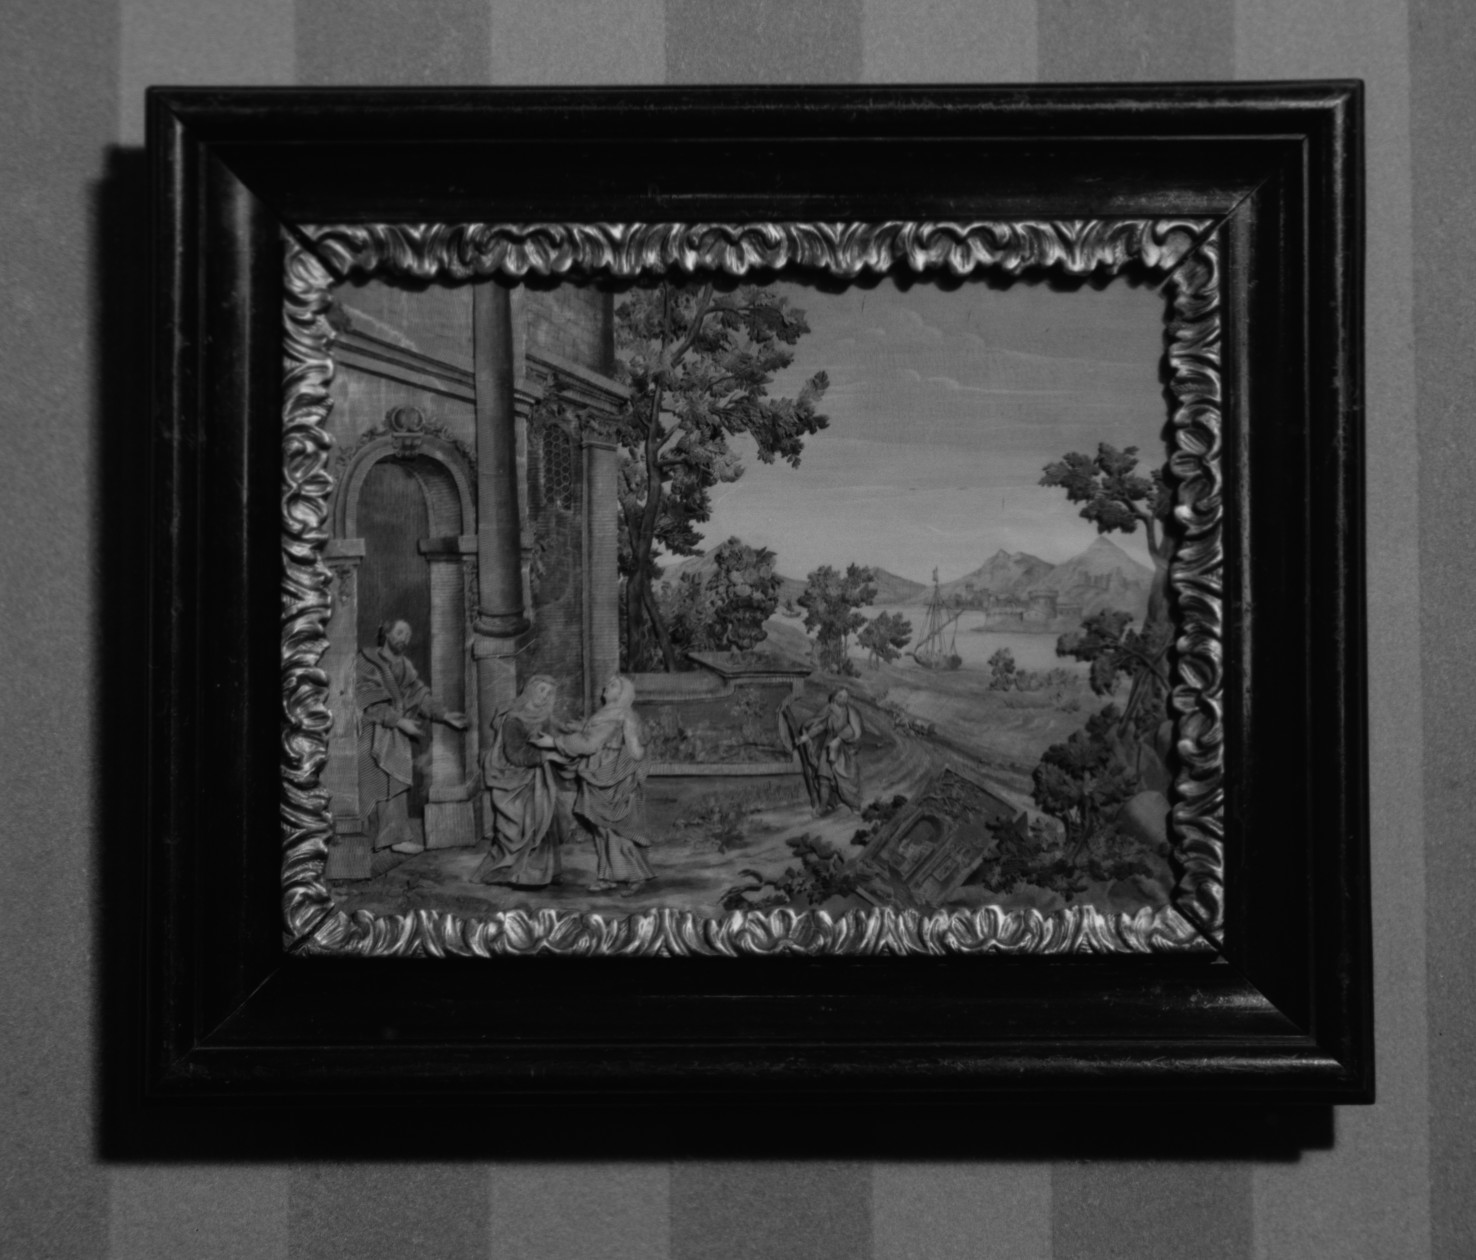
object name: collage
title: The Visitation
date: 1601-1800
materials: canvas, glass, linen, paint, paper, silk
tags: doorways,men,landscapes,trees,virgin mary